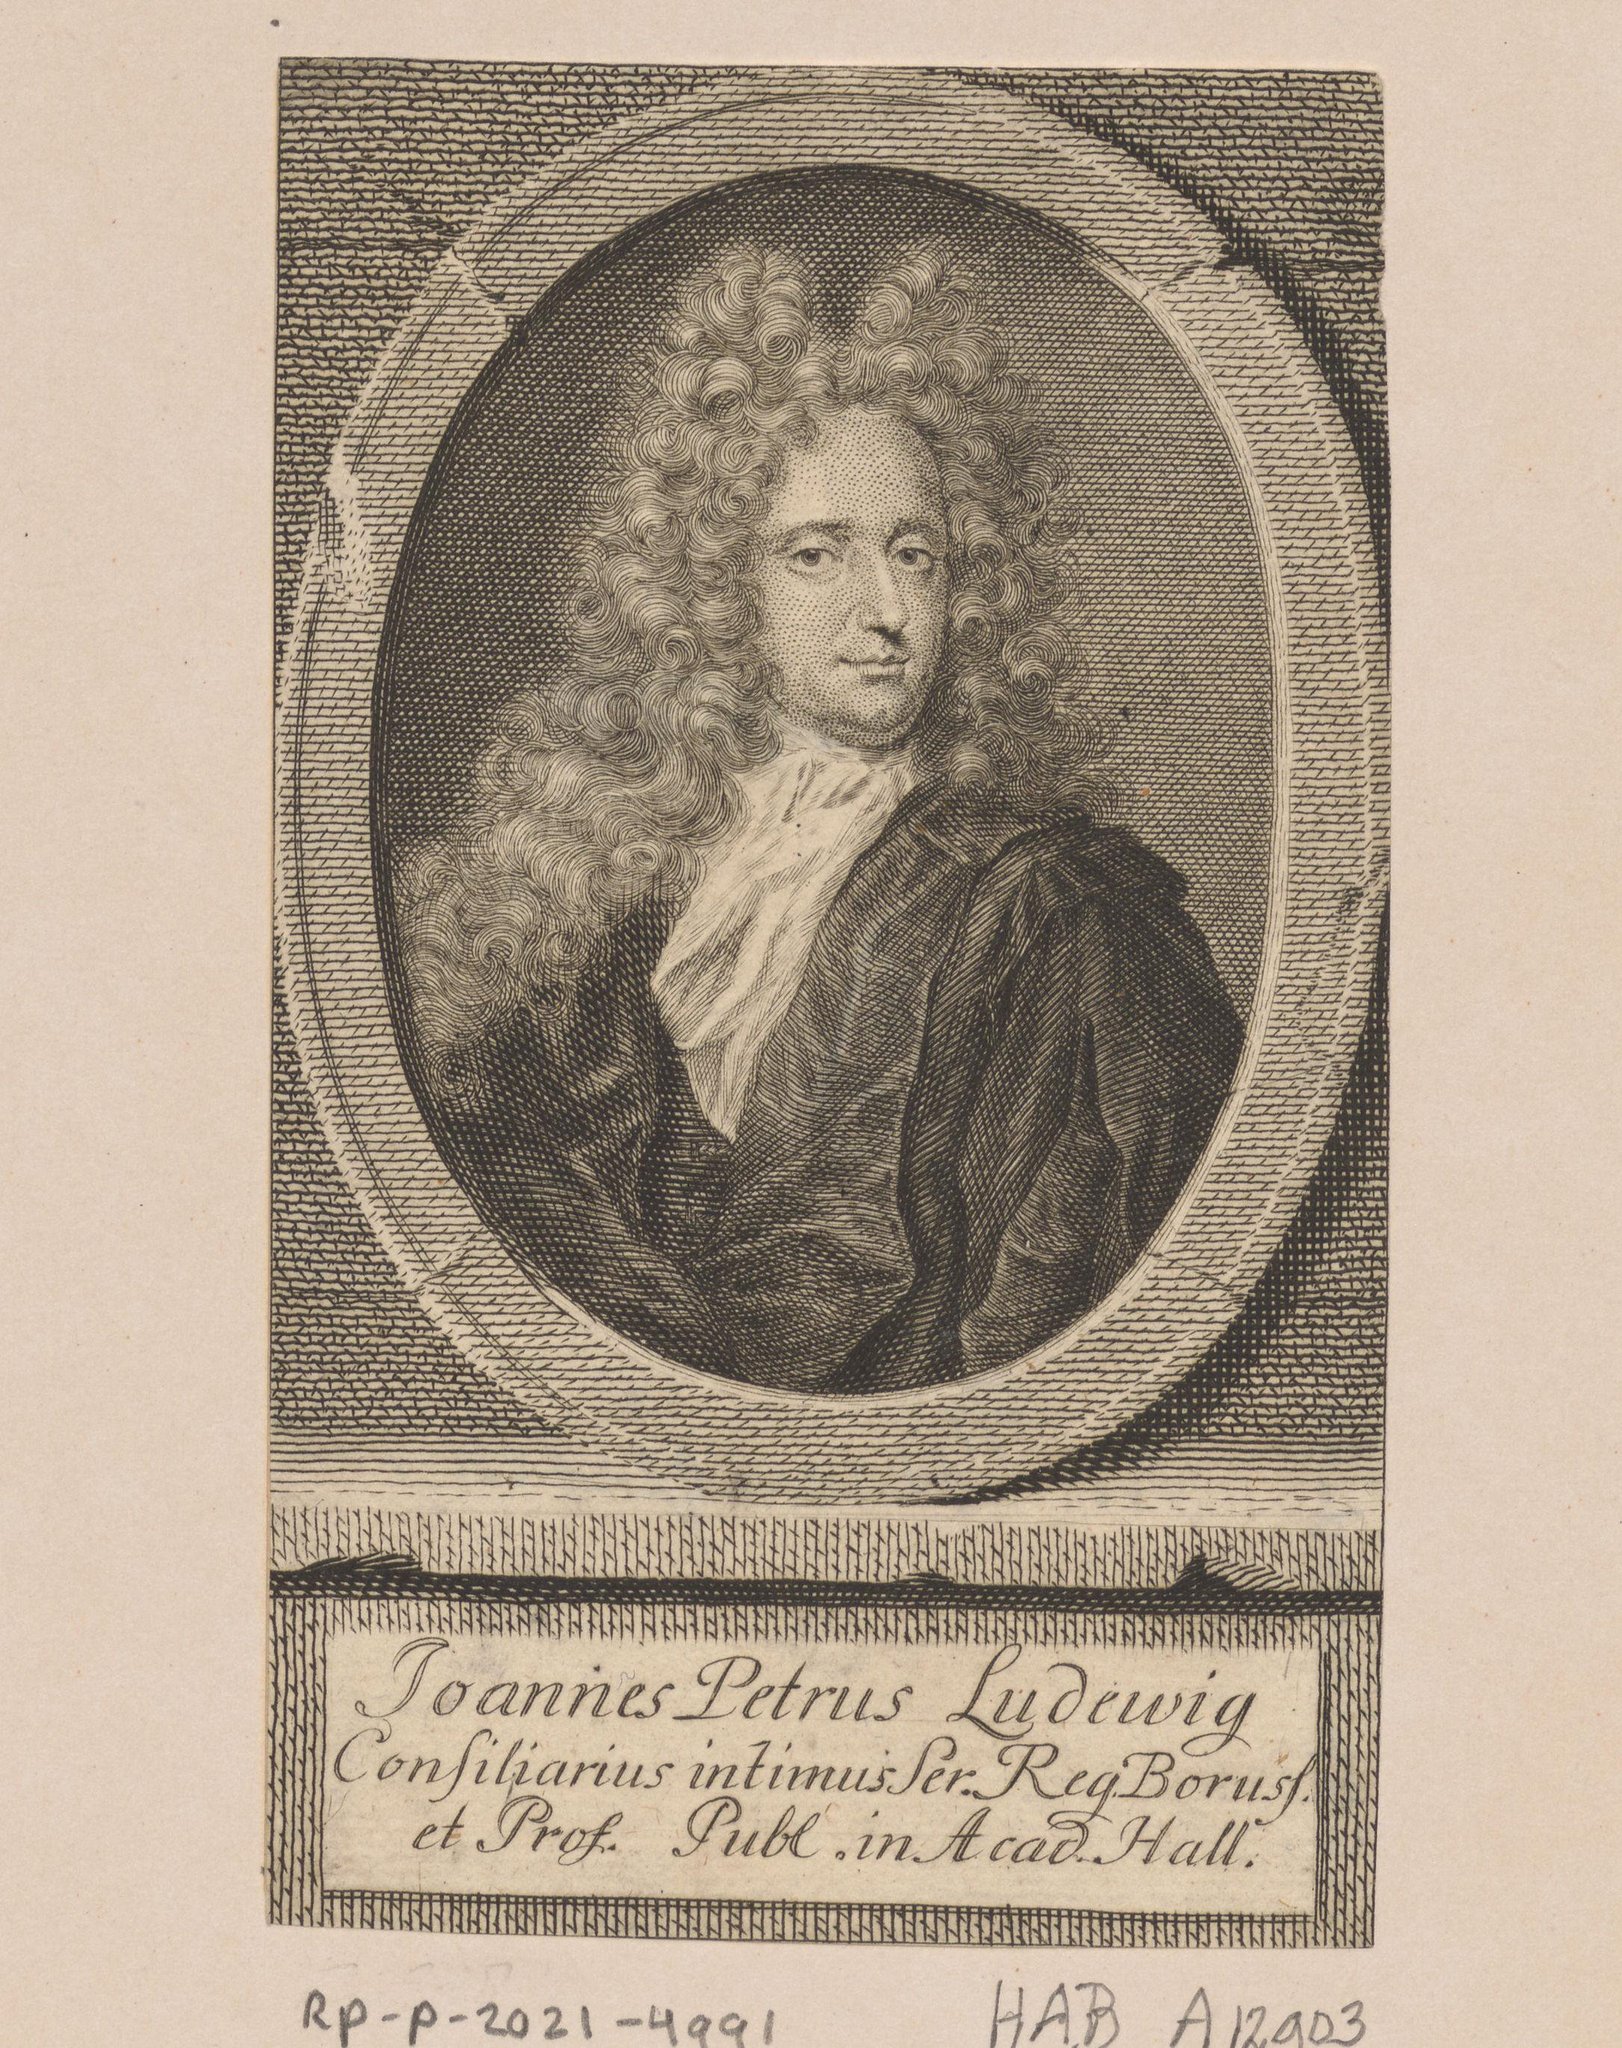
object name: book illustration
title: Portret van Johann Peter von Ludewig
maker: martin bernigeroth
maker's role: print maker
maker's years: 1670-1733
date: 1720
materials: paper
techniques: engraving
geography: germany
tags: ornament ~ medallion, historical persons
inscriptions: collector's mark: Lugt 2228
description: Prent waarschijnlijk uit: Deutsche Acta Eruditorum (...). Leipzig: Johann Gottlieb Gleditsch, 1720, dl. 65.